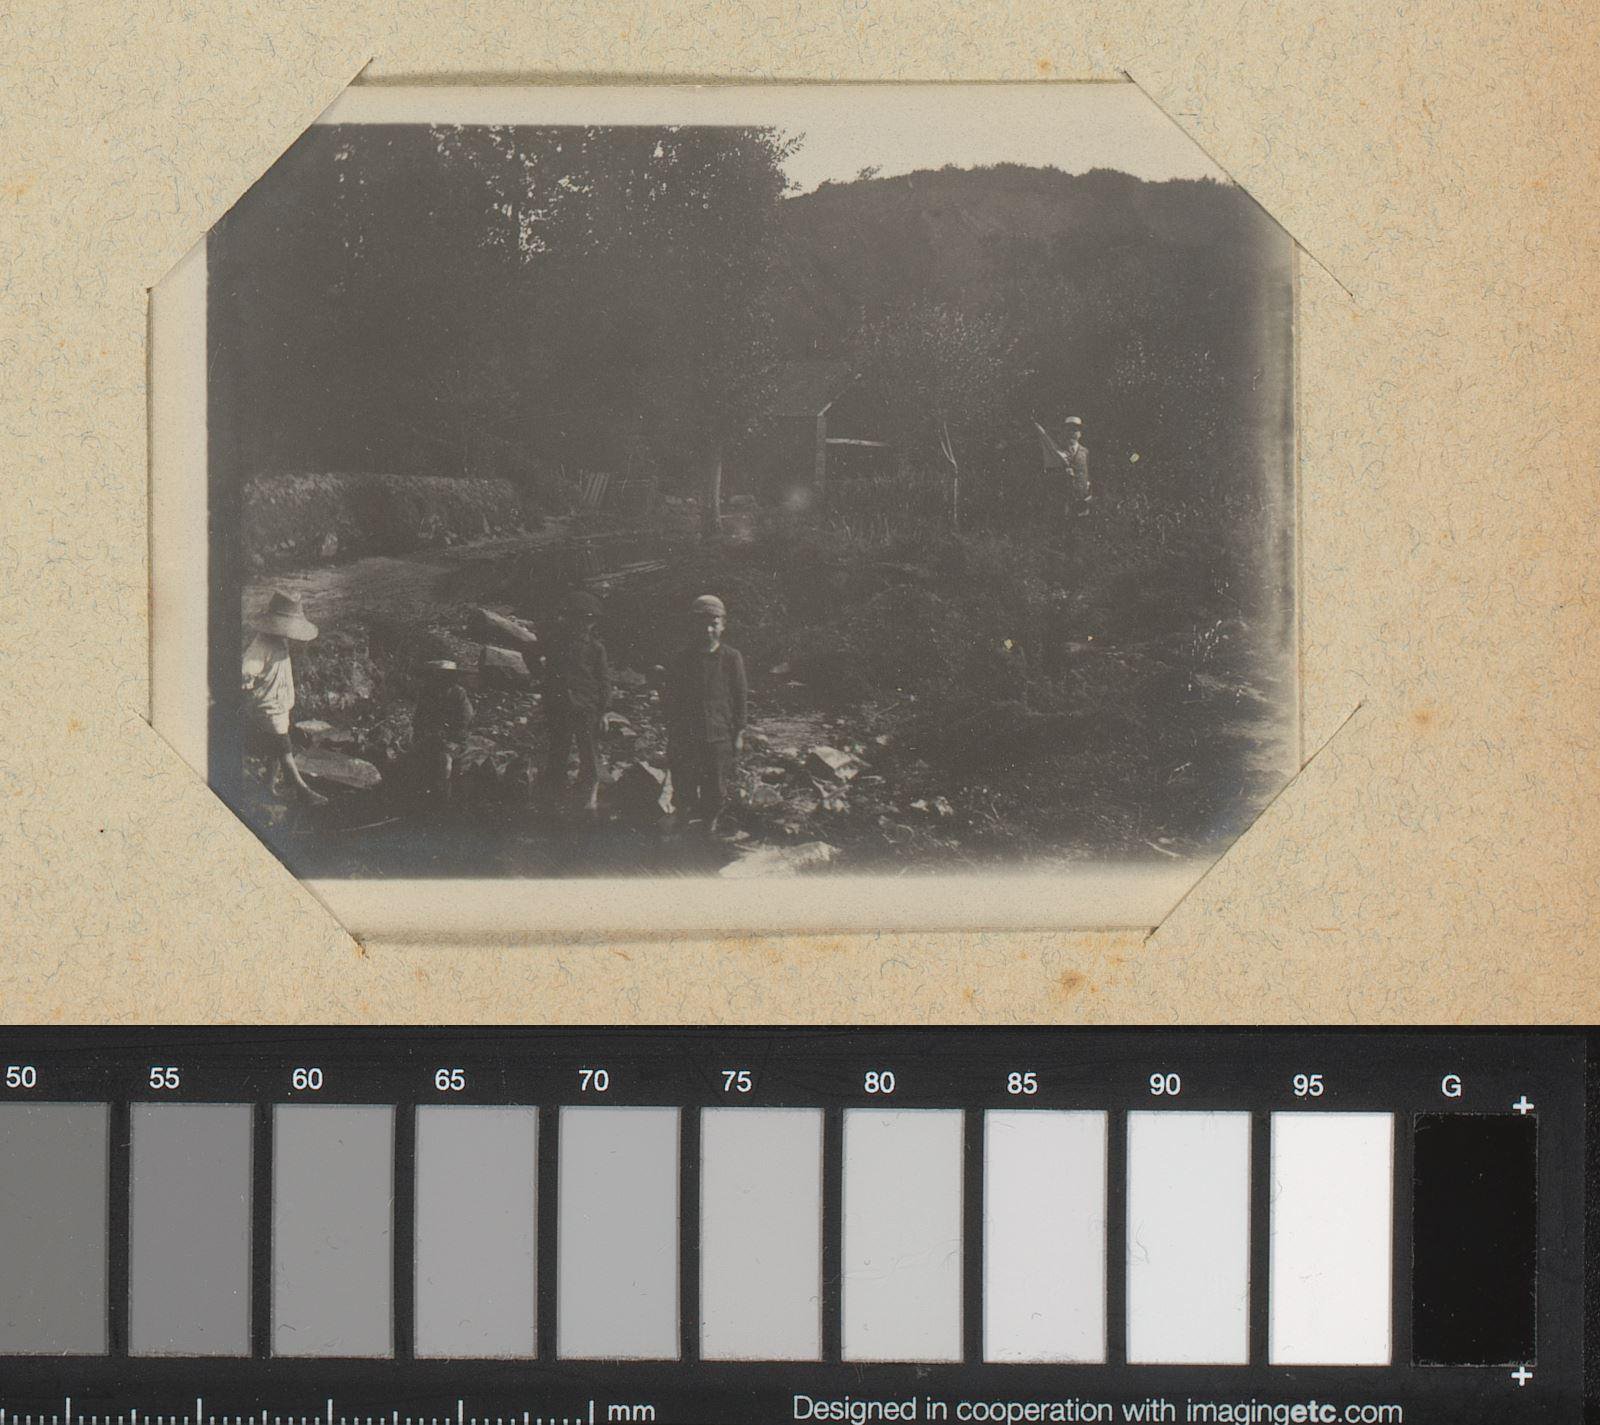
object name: photograph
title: Kinderen in een veld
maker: Anonymous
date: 1897-1900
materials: paper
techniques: gelatin silver print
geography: france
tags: child, france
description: Over de foto is een ander negatief afgedrukt van een voorstelling van bomen.